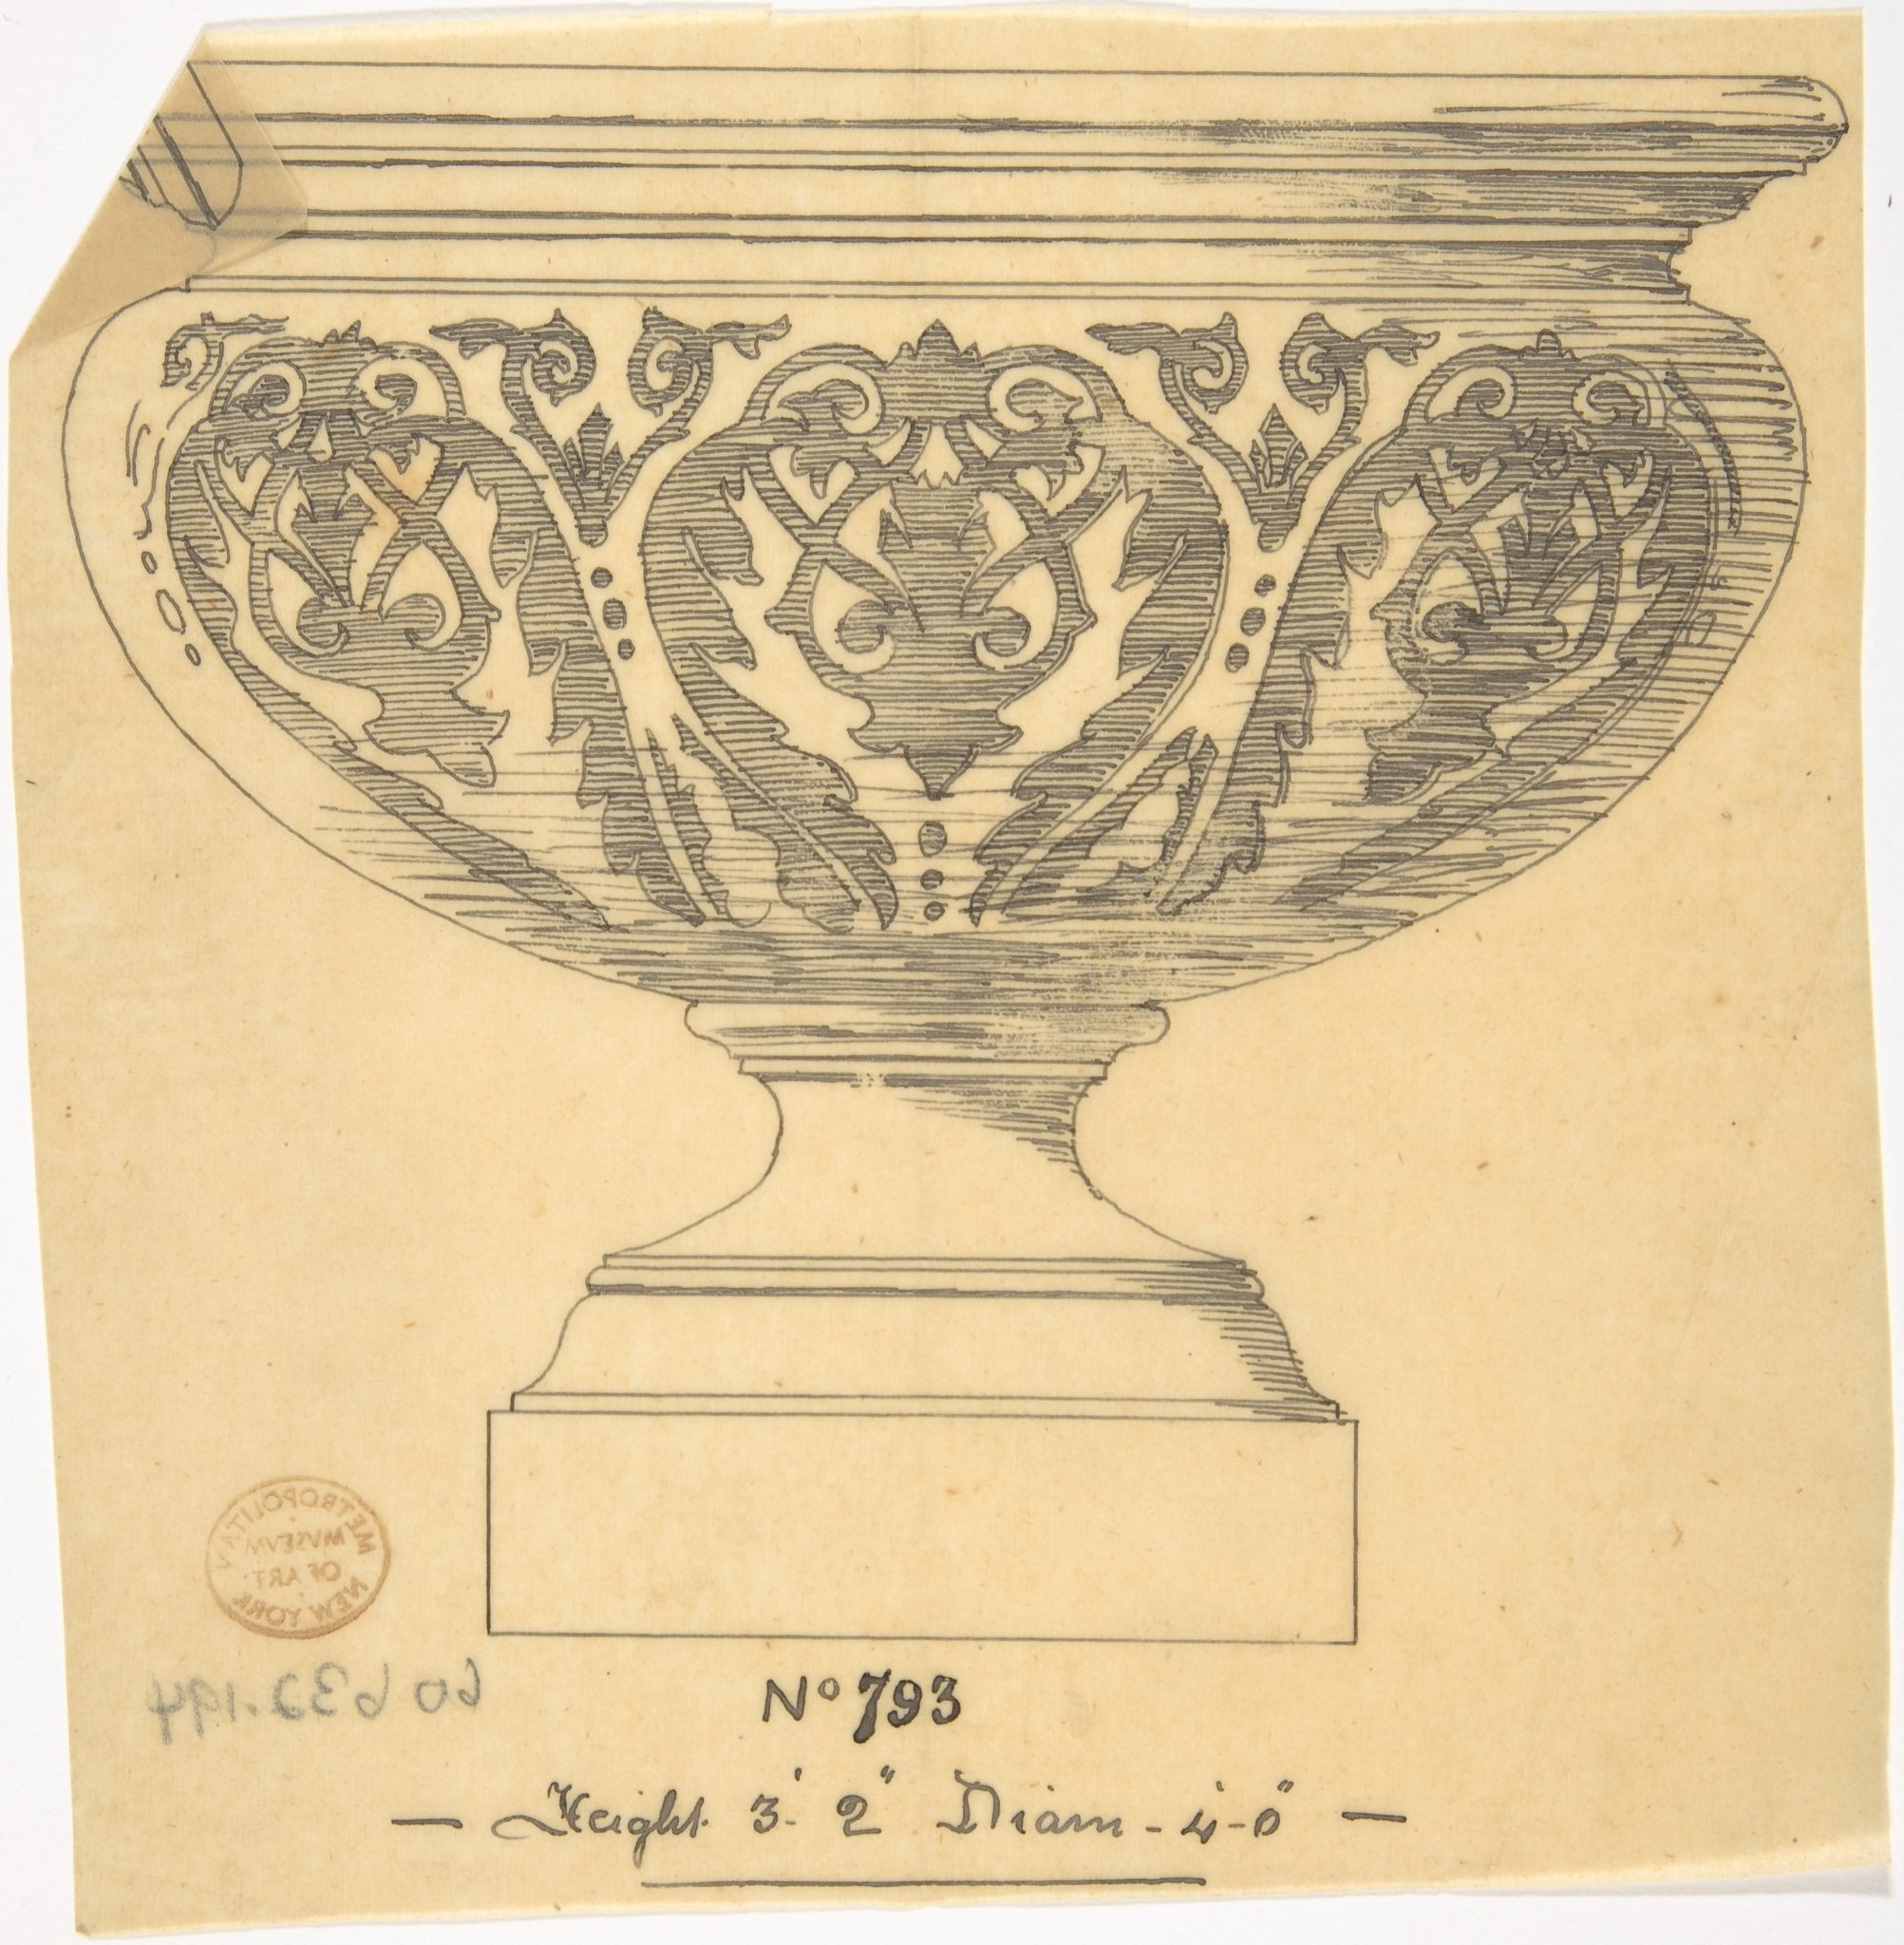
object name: drawing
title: Vase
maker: anonymous, british, 19th century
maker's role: artist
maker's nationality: british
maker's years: 1800-1900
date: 1801-1900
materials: ink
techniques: pen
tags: vases